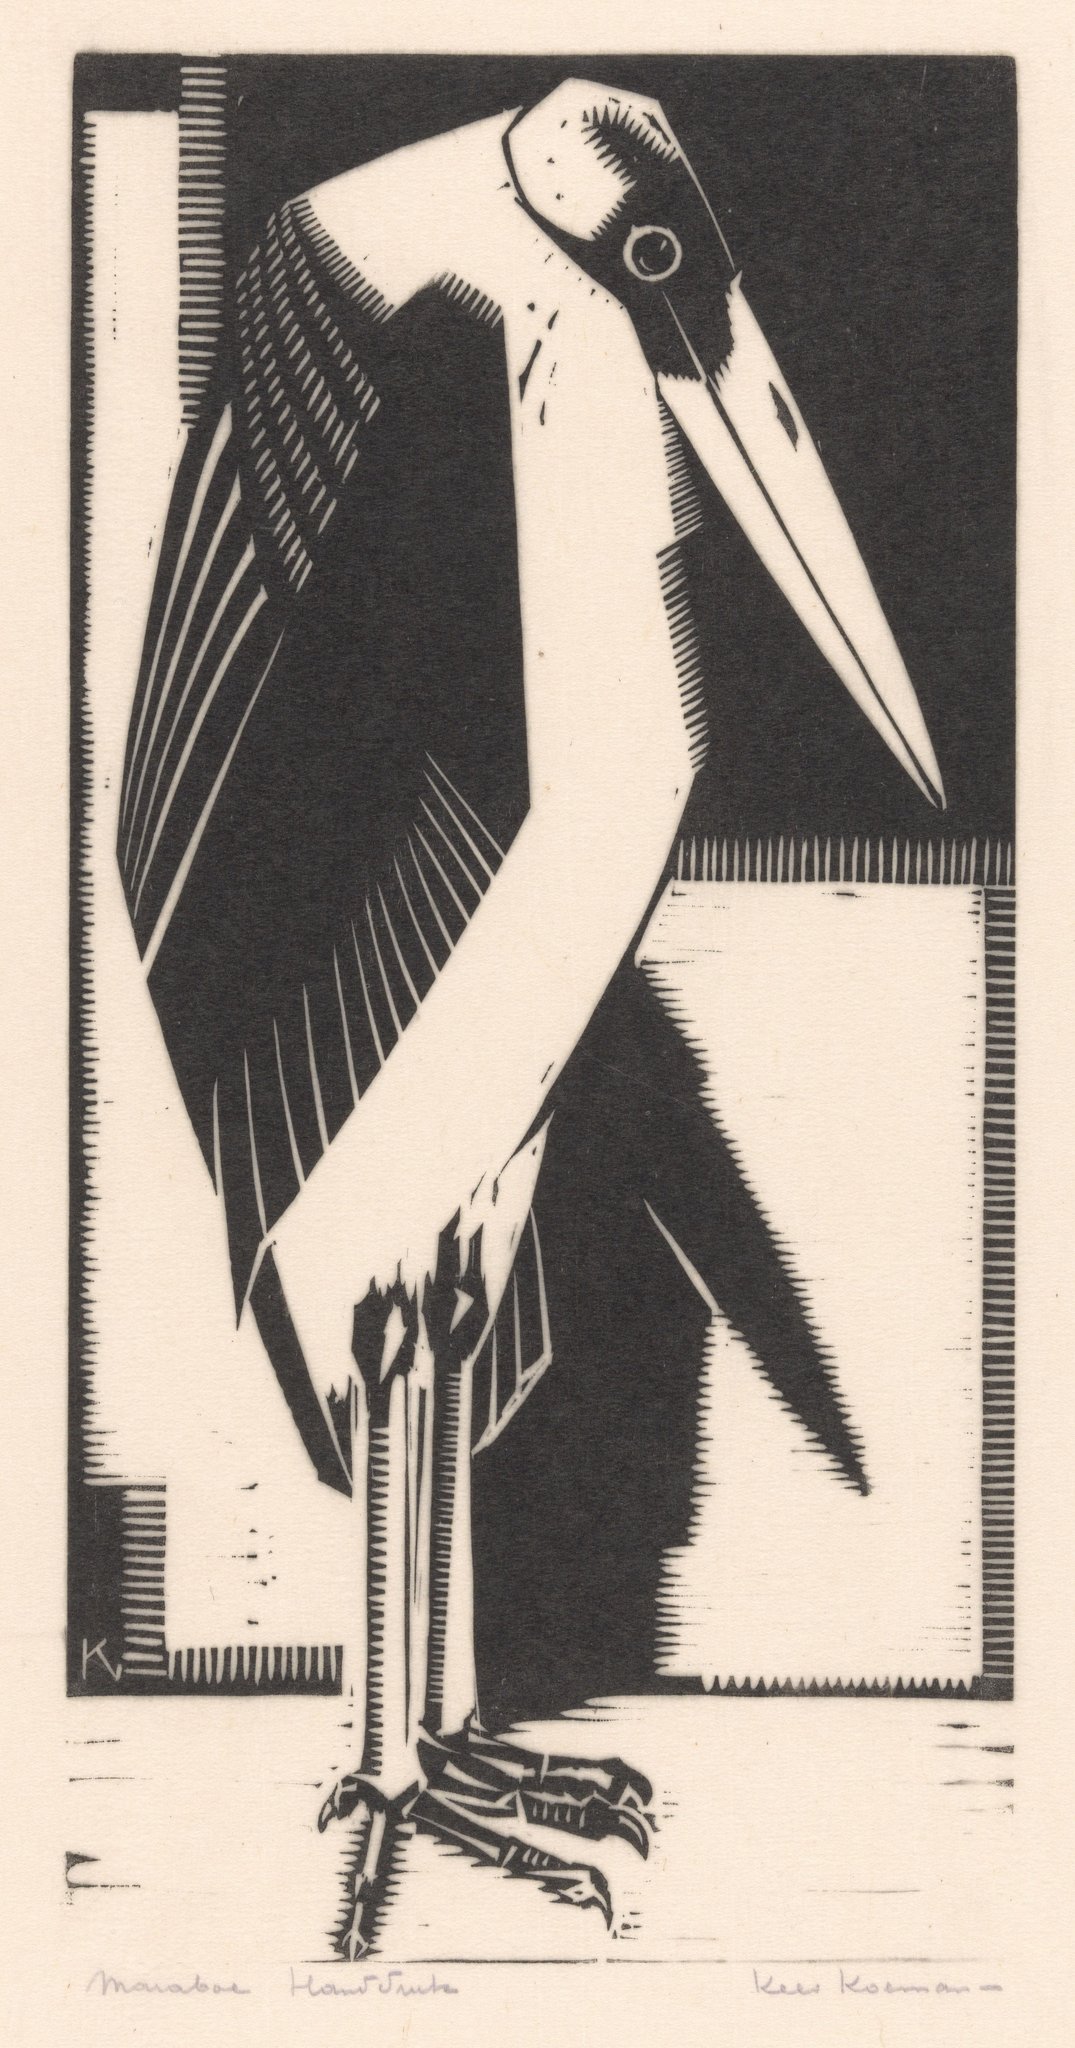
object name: print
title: Maraboe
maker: kees koeman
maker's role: print maker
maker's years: 1895-1954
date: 1910-1932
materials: paper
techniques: woodcut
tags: shore-birds and wading-birds: marabou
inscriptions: collector's mark: Lugt 2228